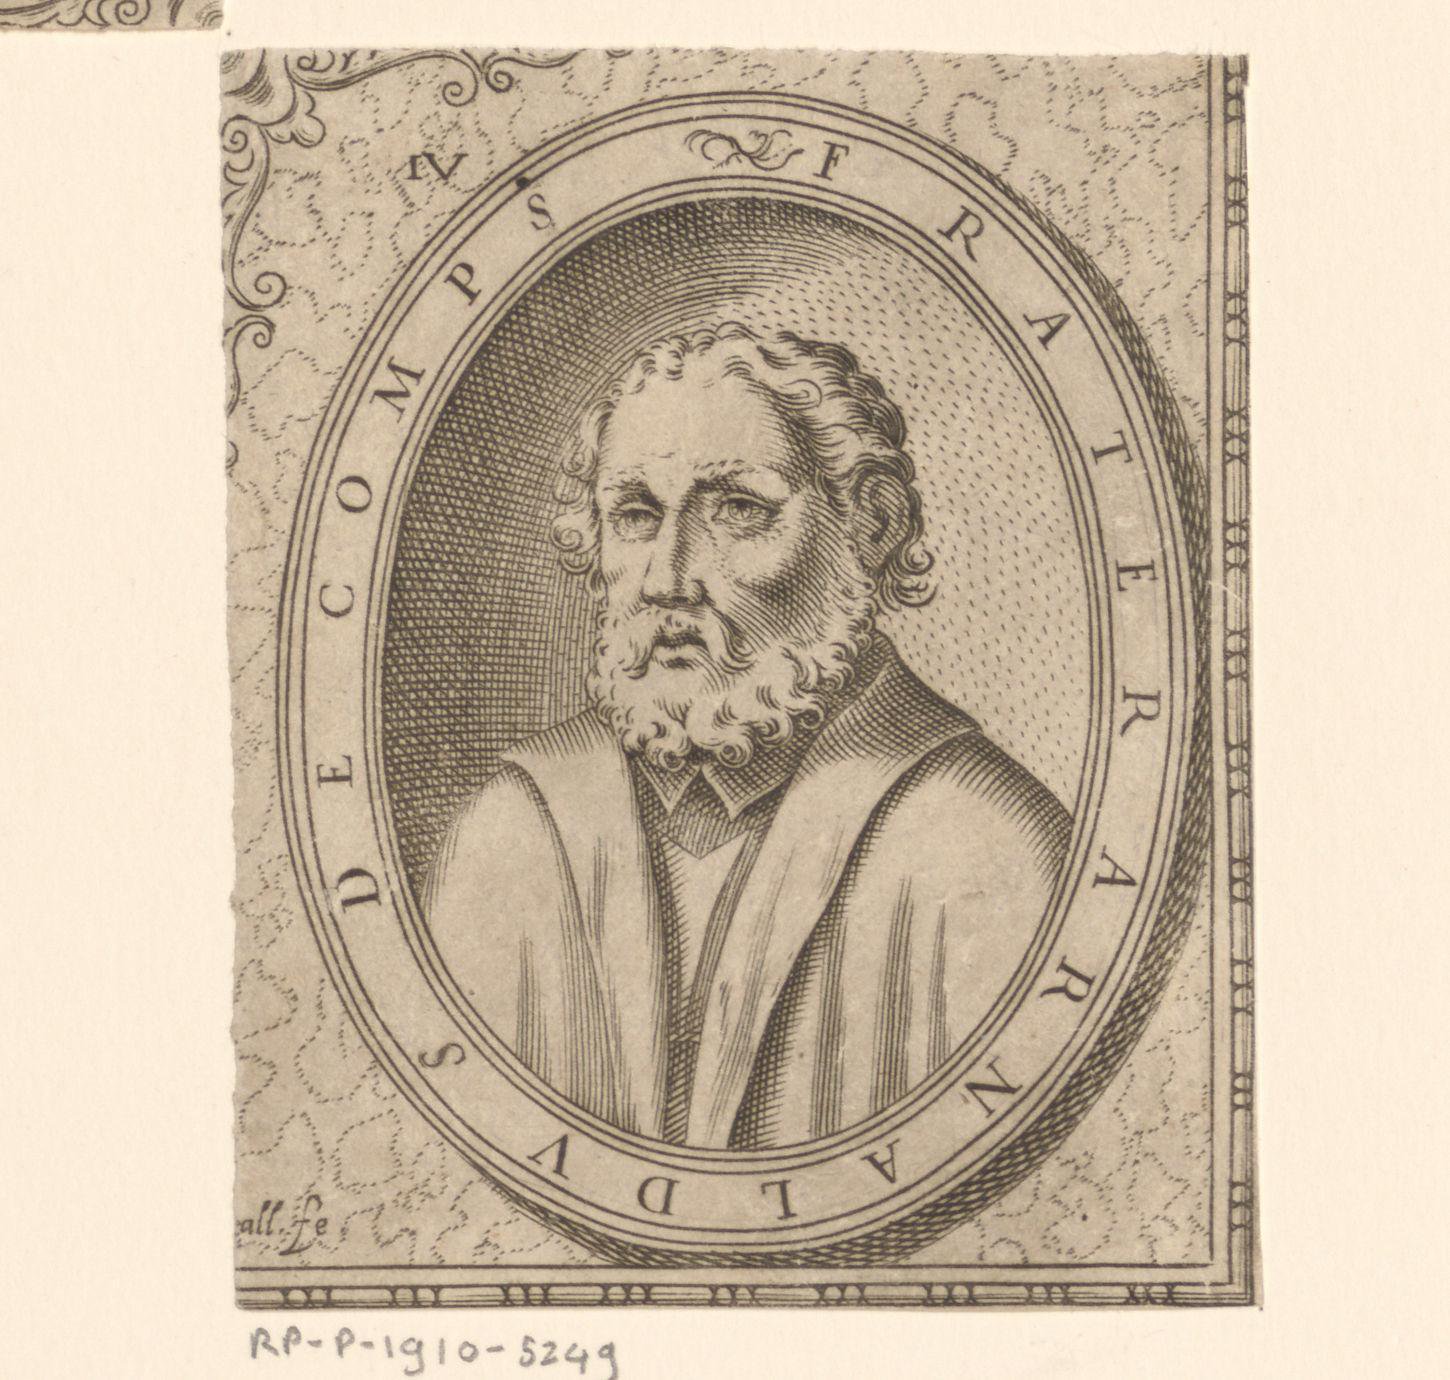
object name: print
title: Portret van Arnaud de Comps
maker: philippe thomassin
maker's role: print maker, publisher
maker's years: 1562-1622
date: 1588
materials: paper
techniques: engraving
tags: historical persons, military orders, e.g.: knights templars, knights of malta, teutonic knights ~ roman catholic church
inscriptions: collector's mark: Lugt 2228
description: Deze prent maakt deel uit van een grotere prent met vier portretten die later is verknipt. Prent waarschijnlijk uit: Veltroni, Tolomeo. Statuta hospitalis Hierusalem. [Rome: s.n., 1588].